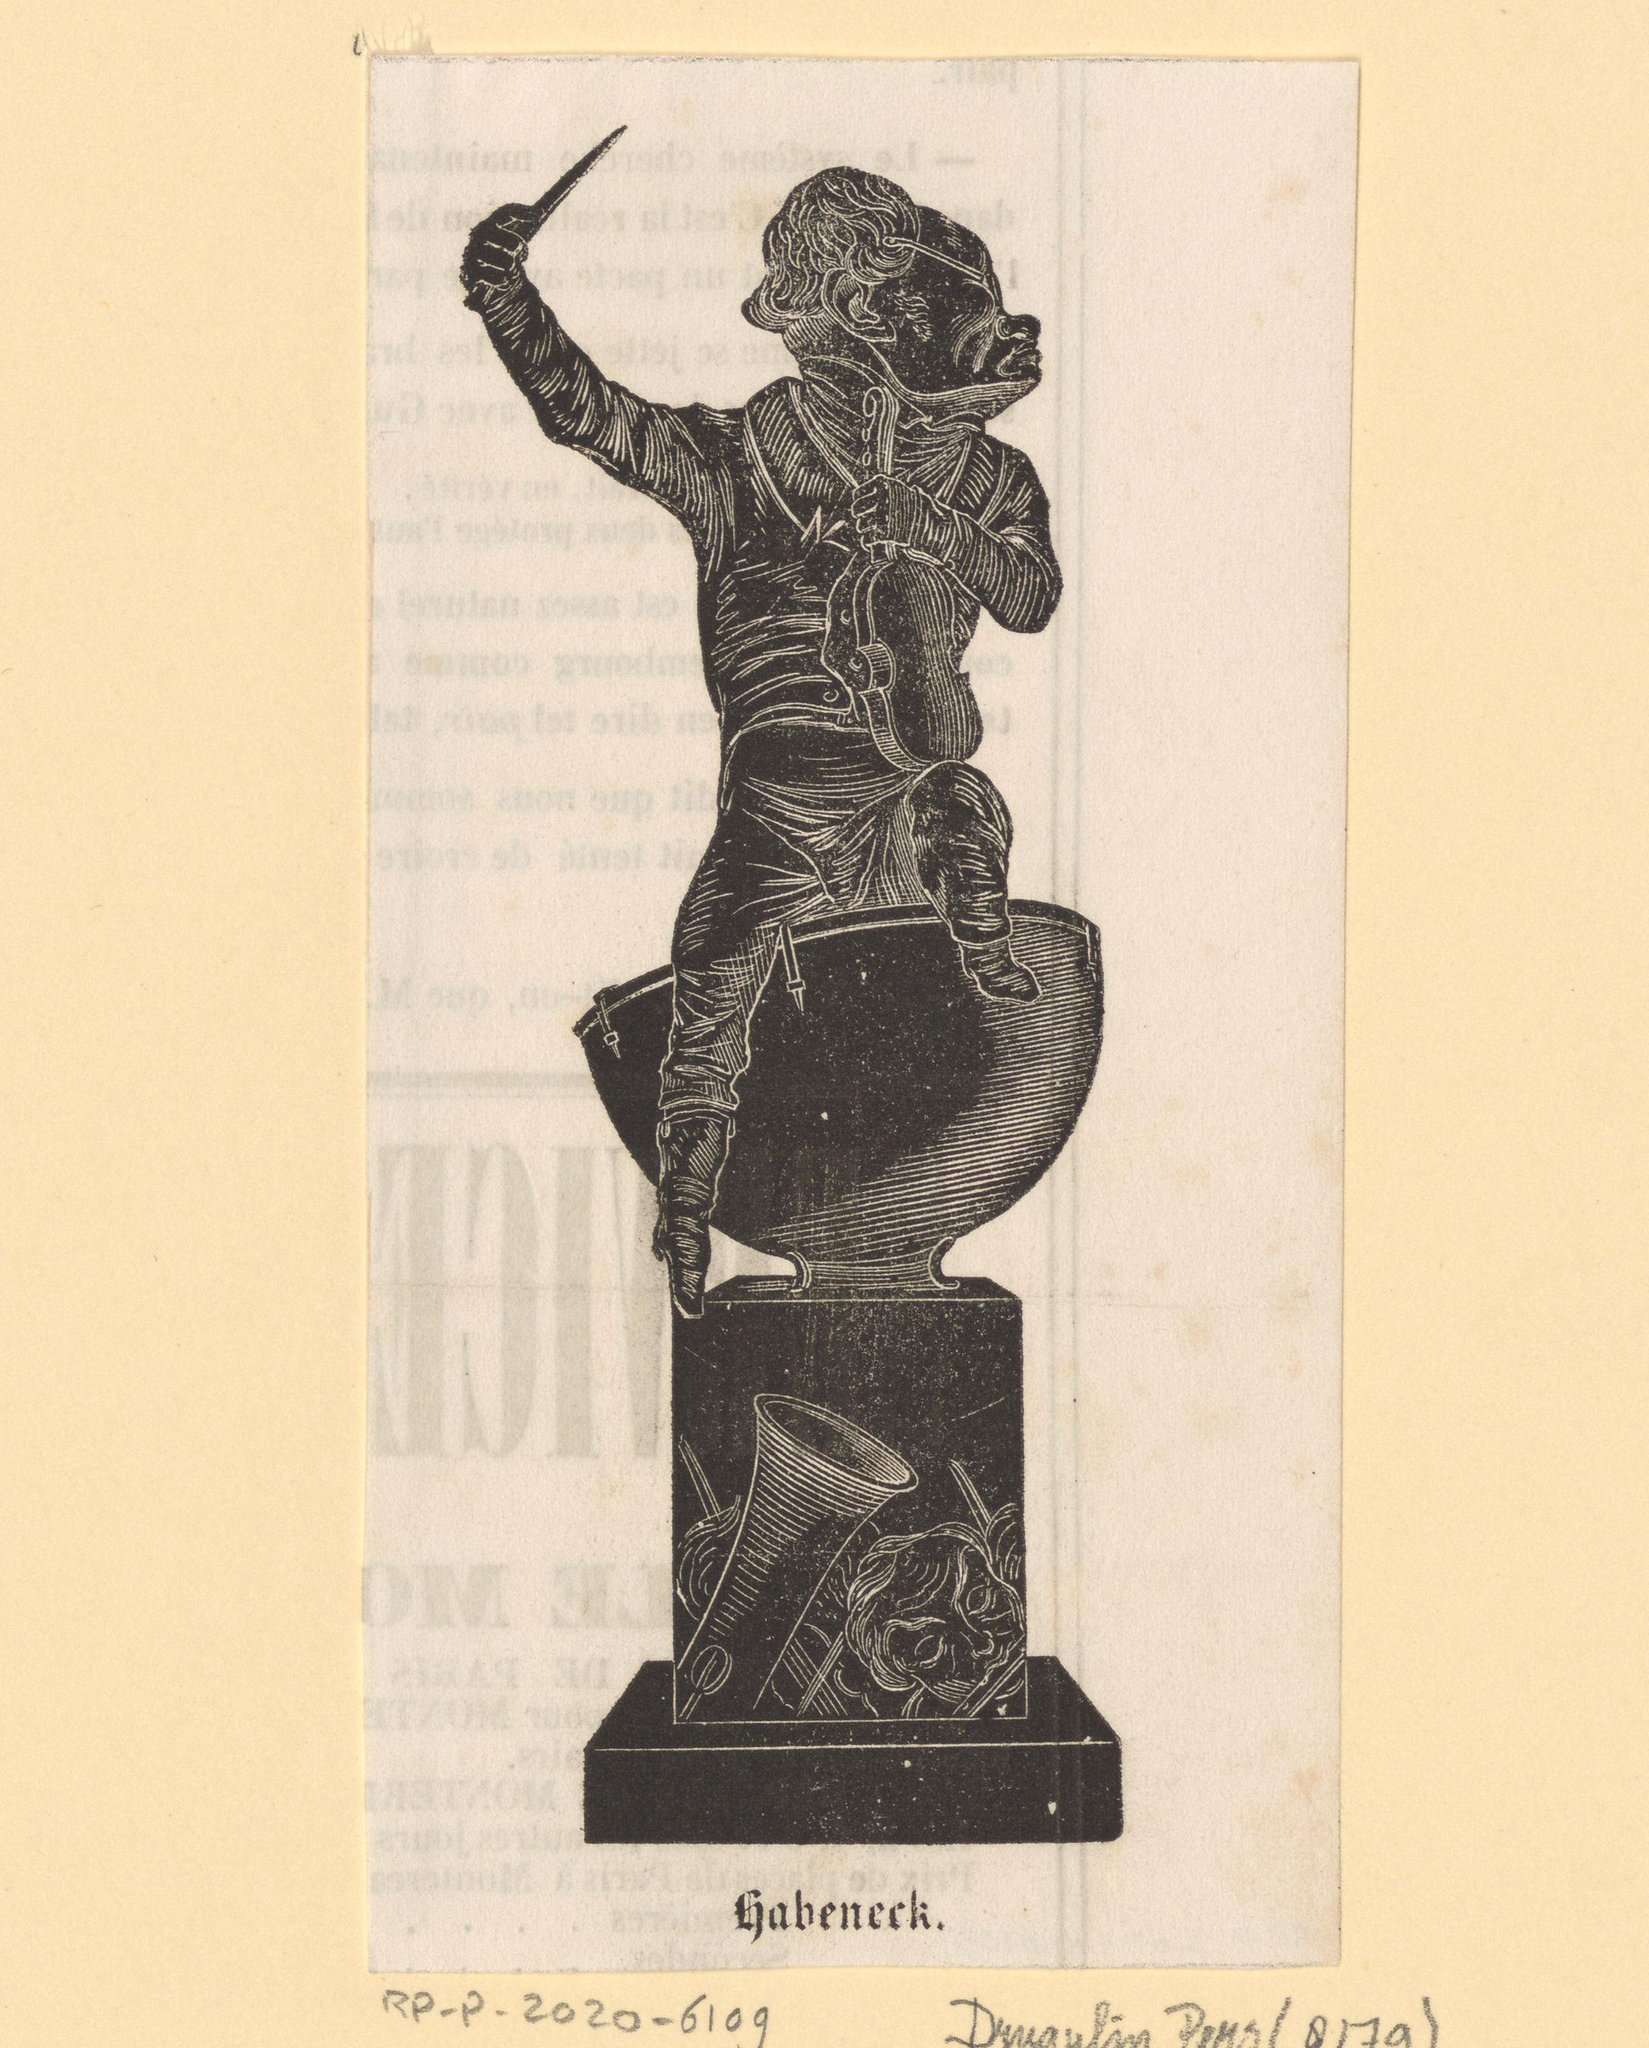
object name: print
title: Standbeeld van François-Antoine Habeneck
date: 1832-1849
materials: paper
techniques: letterpress printing, engraving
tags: paris, historical persons, portrait of composer, piece of sculpture, reproduction of a piece of sculpture